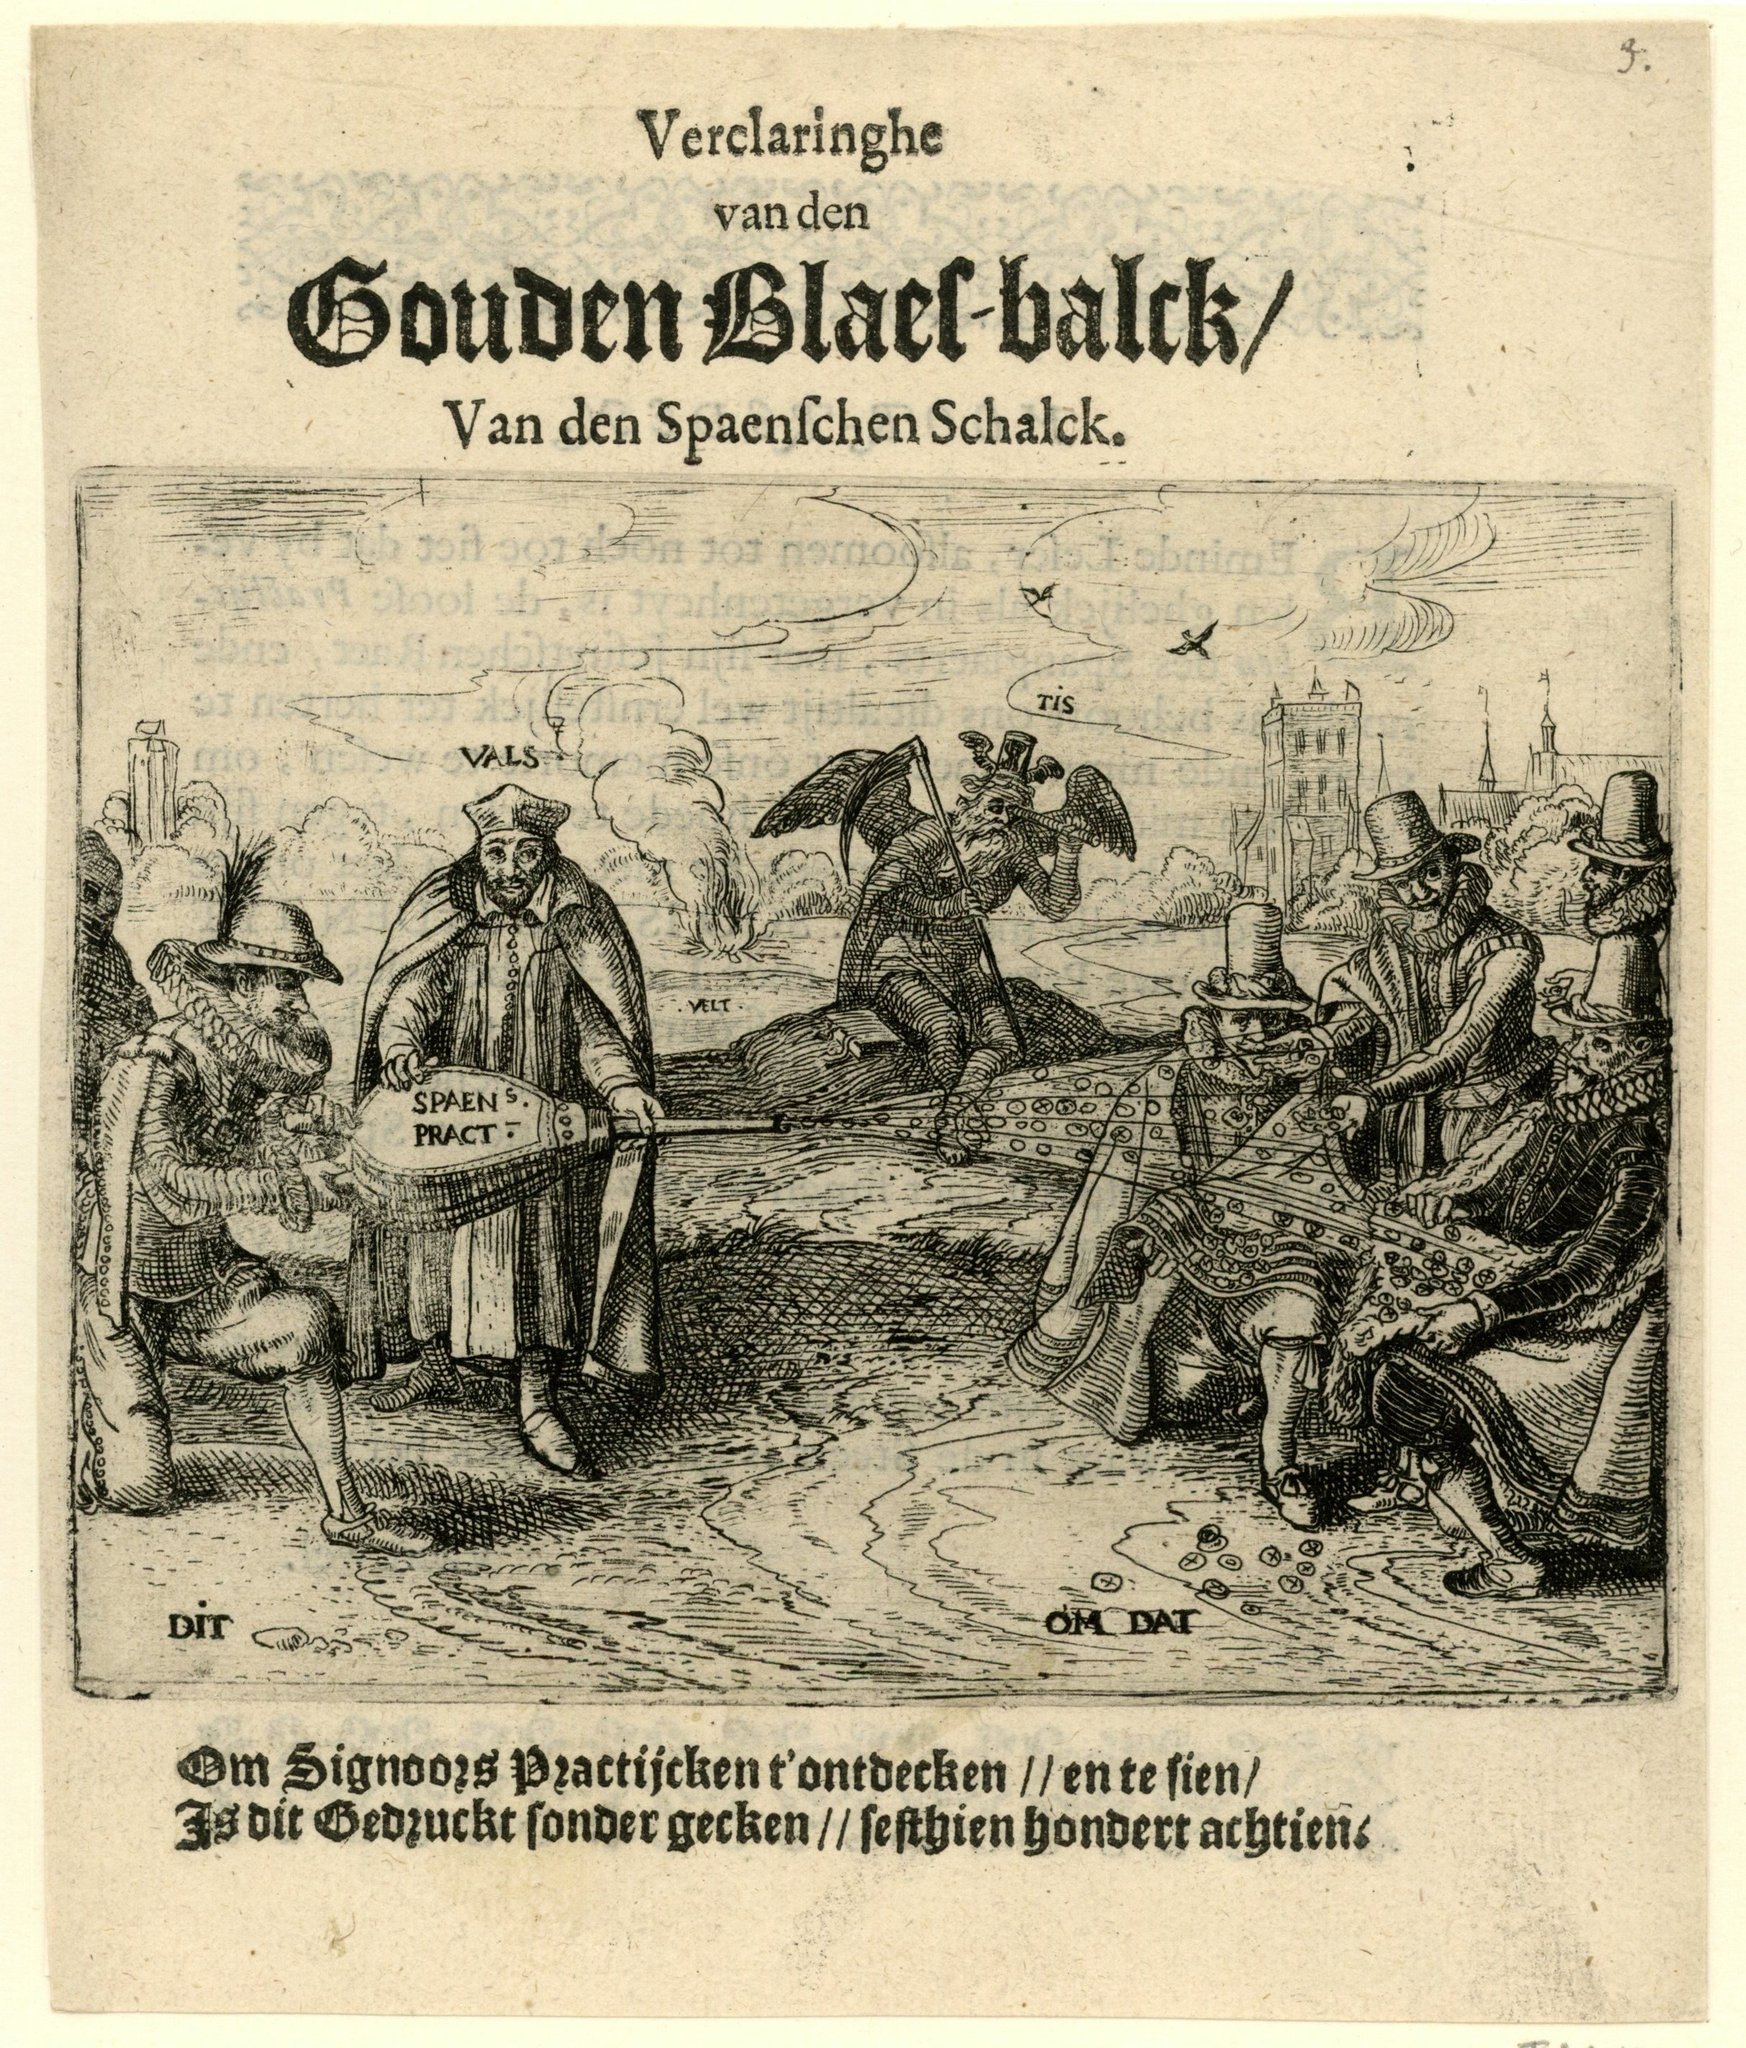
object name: print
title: Verclaringhe van den Gouden Blaes-balck / Van den Spaenschen Schalck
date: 1618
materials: paper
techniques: etching, letterpress printing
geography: northern netherlands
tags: the hague, johan van oldenbarnevelt, bellows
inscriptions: date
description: Titelprent van het pamflet uit 1618 getiteld 'Verclaringhe van den Gouden Blaes-balck / Van den Spaenschen Schalck'. In de voorstelling schieten een Spanjaard en een jezuïet met een blaasbalg goudstukken naar Johan van Oldenbarnevelt en enkele anderen. Op de achtergrond kijkt de Tijd door een verrekijker. Onder de prent een tweeregelig versje over 'Signoors Practijcken'.